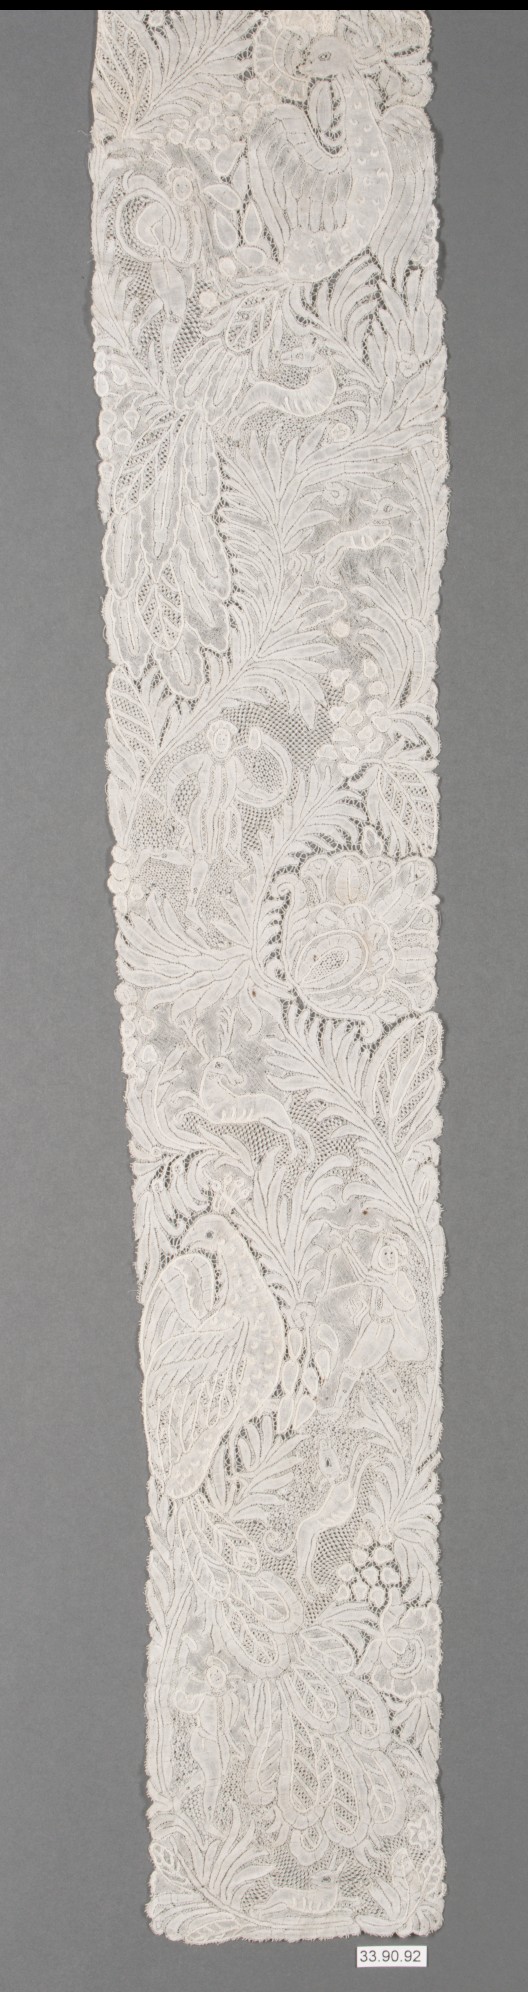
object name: lappet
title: Lappet (one of a pair)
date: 1701-1733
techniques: lace